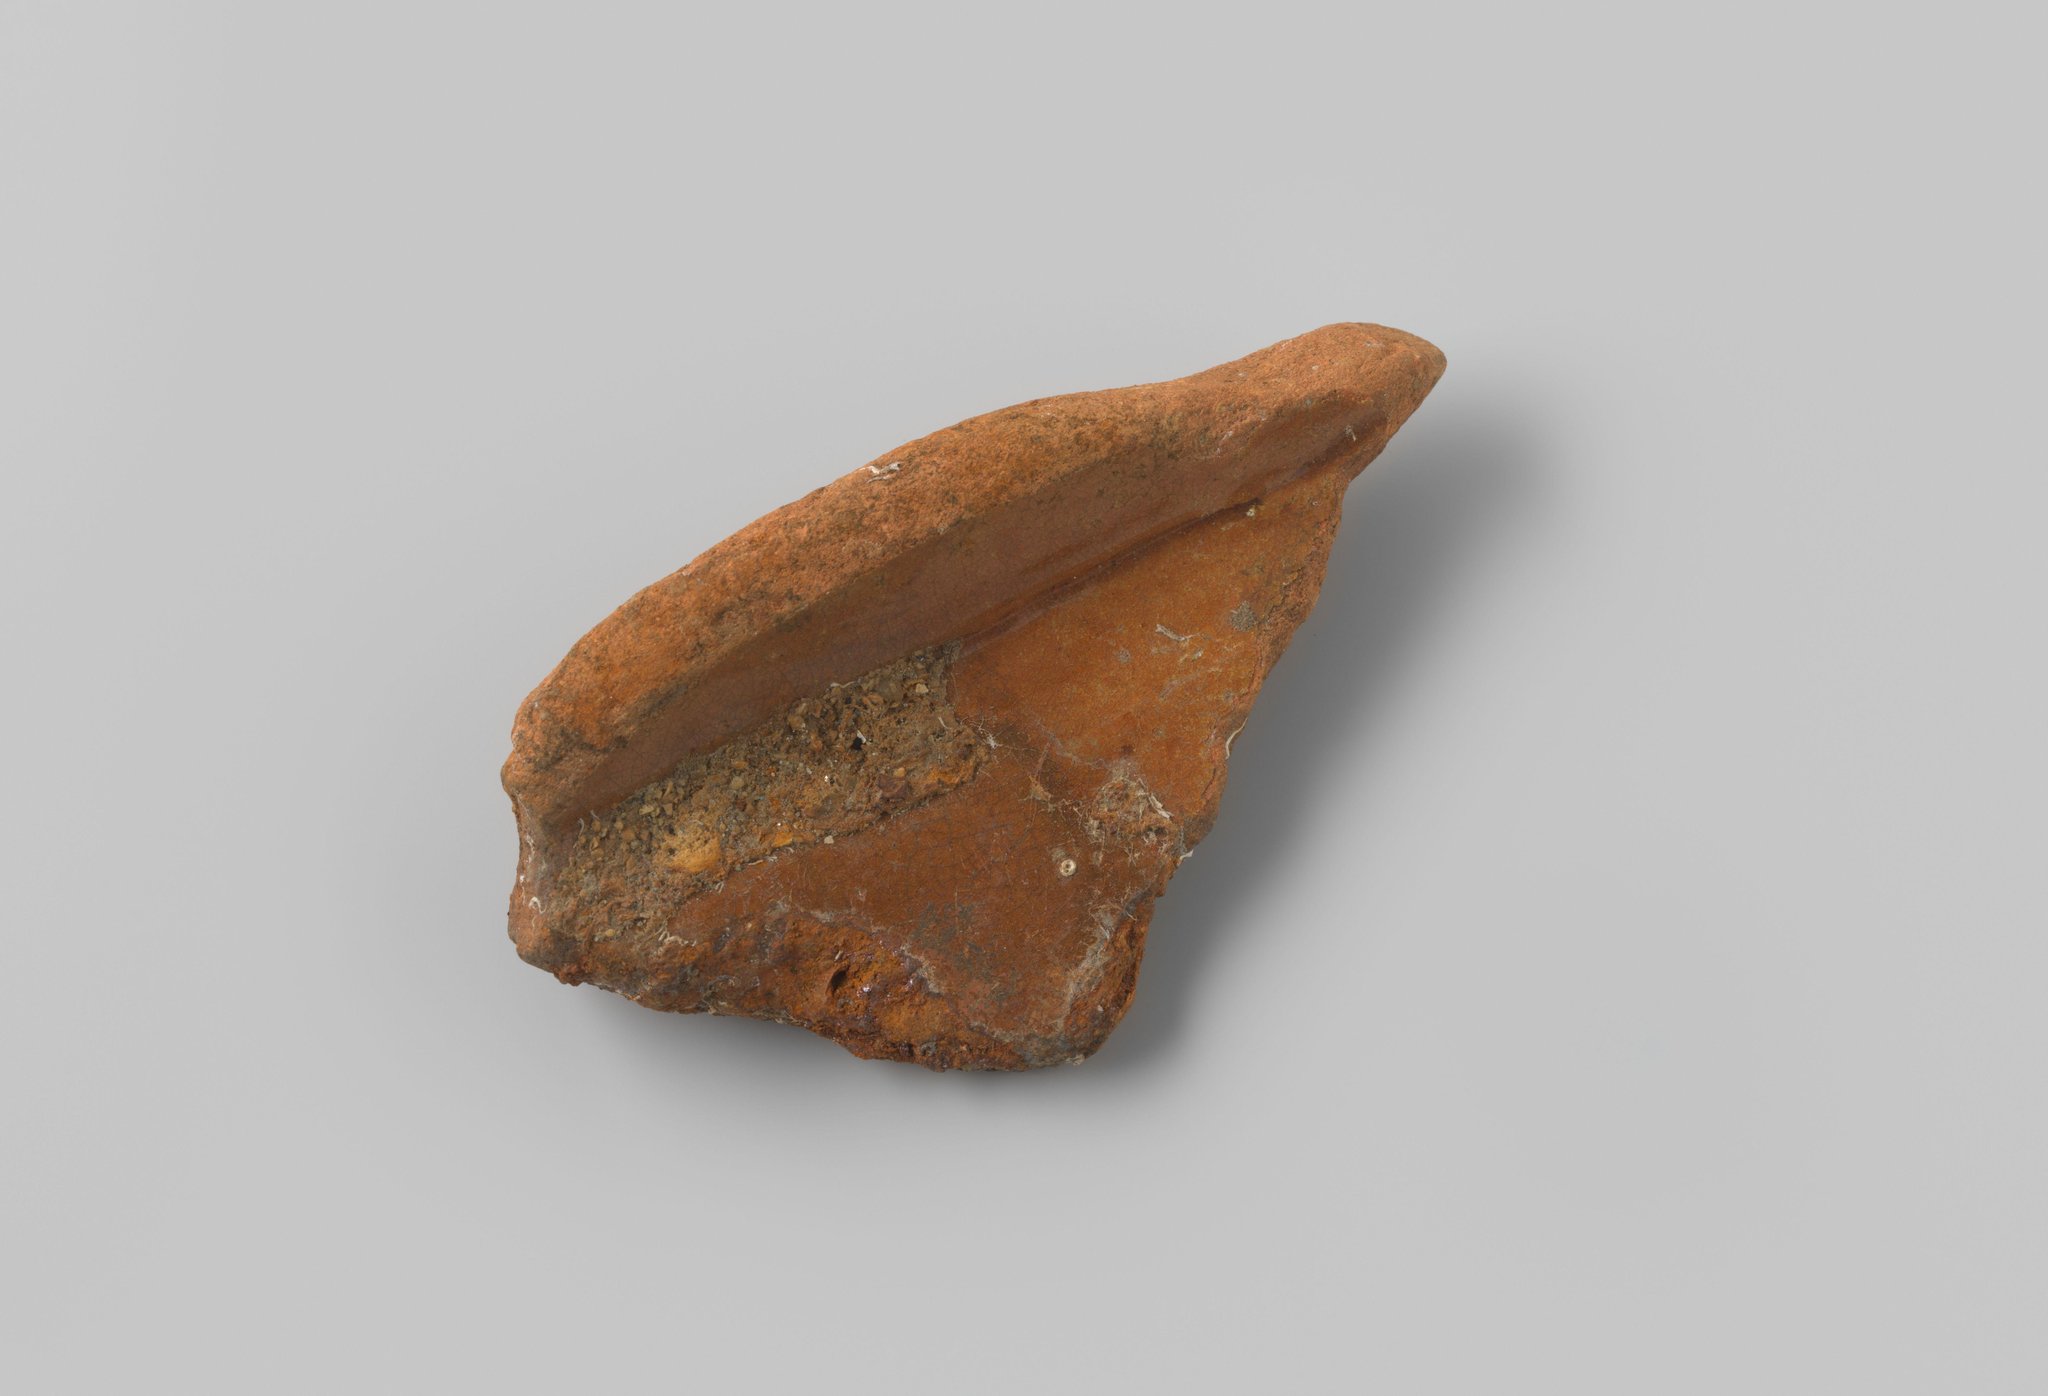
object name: pot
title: Scherf van een pot of schaal uit het wrak van de Oost-Indiëvaarder Hollandia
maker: Anonymous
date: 1700-1743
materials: earthenware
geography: netherlands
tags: verenigde oostindische compagnie, hollandia (schip), annet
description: Earthenware (lead-glazed), pot or dish (hollow ware); fragm of rim, straight, slightly everted, flat inside, eroded.